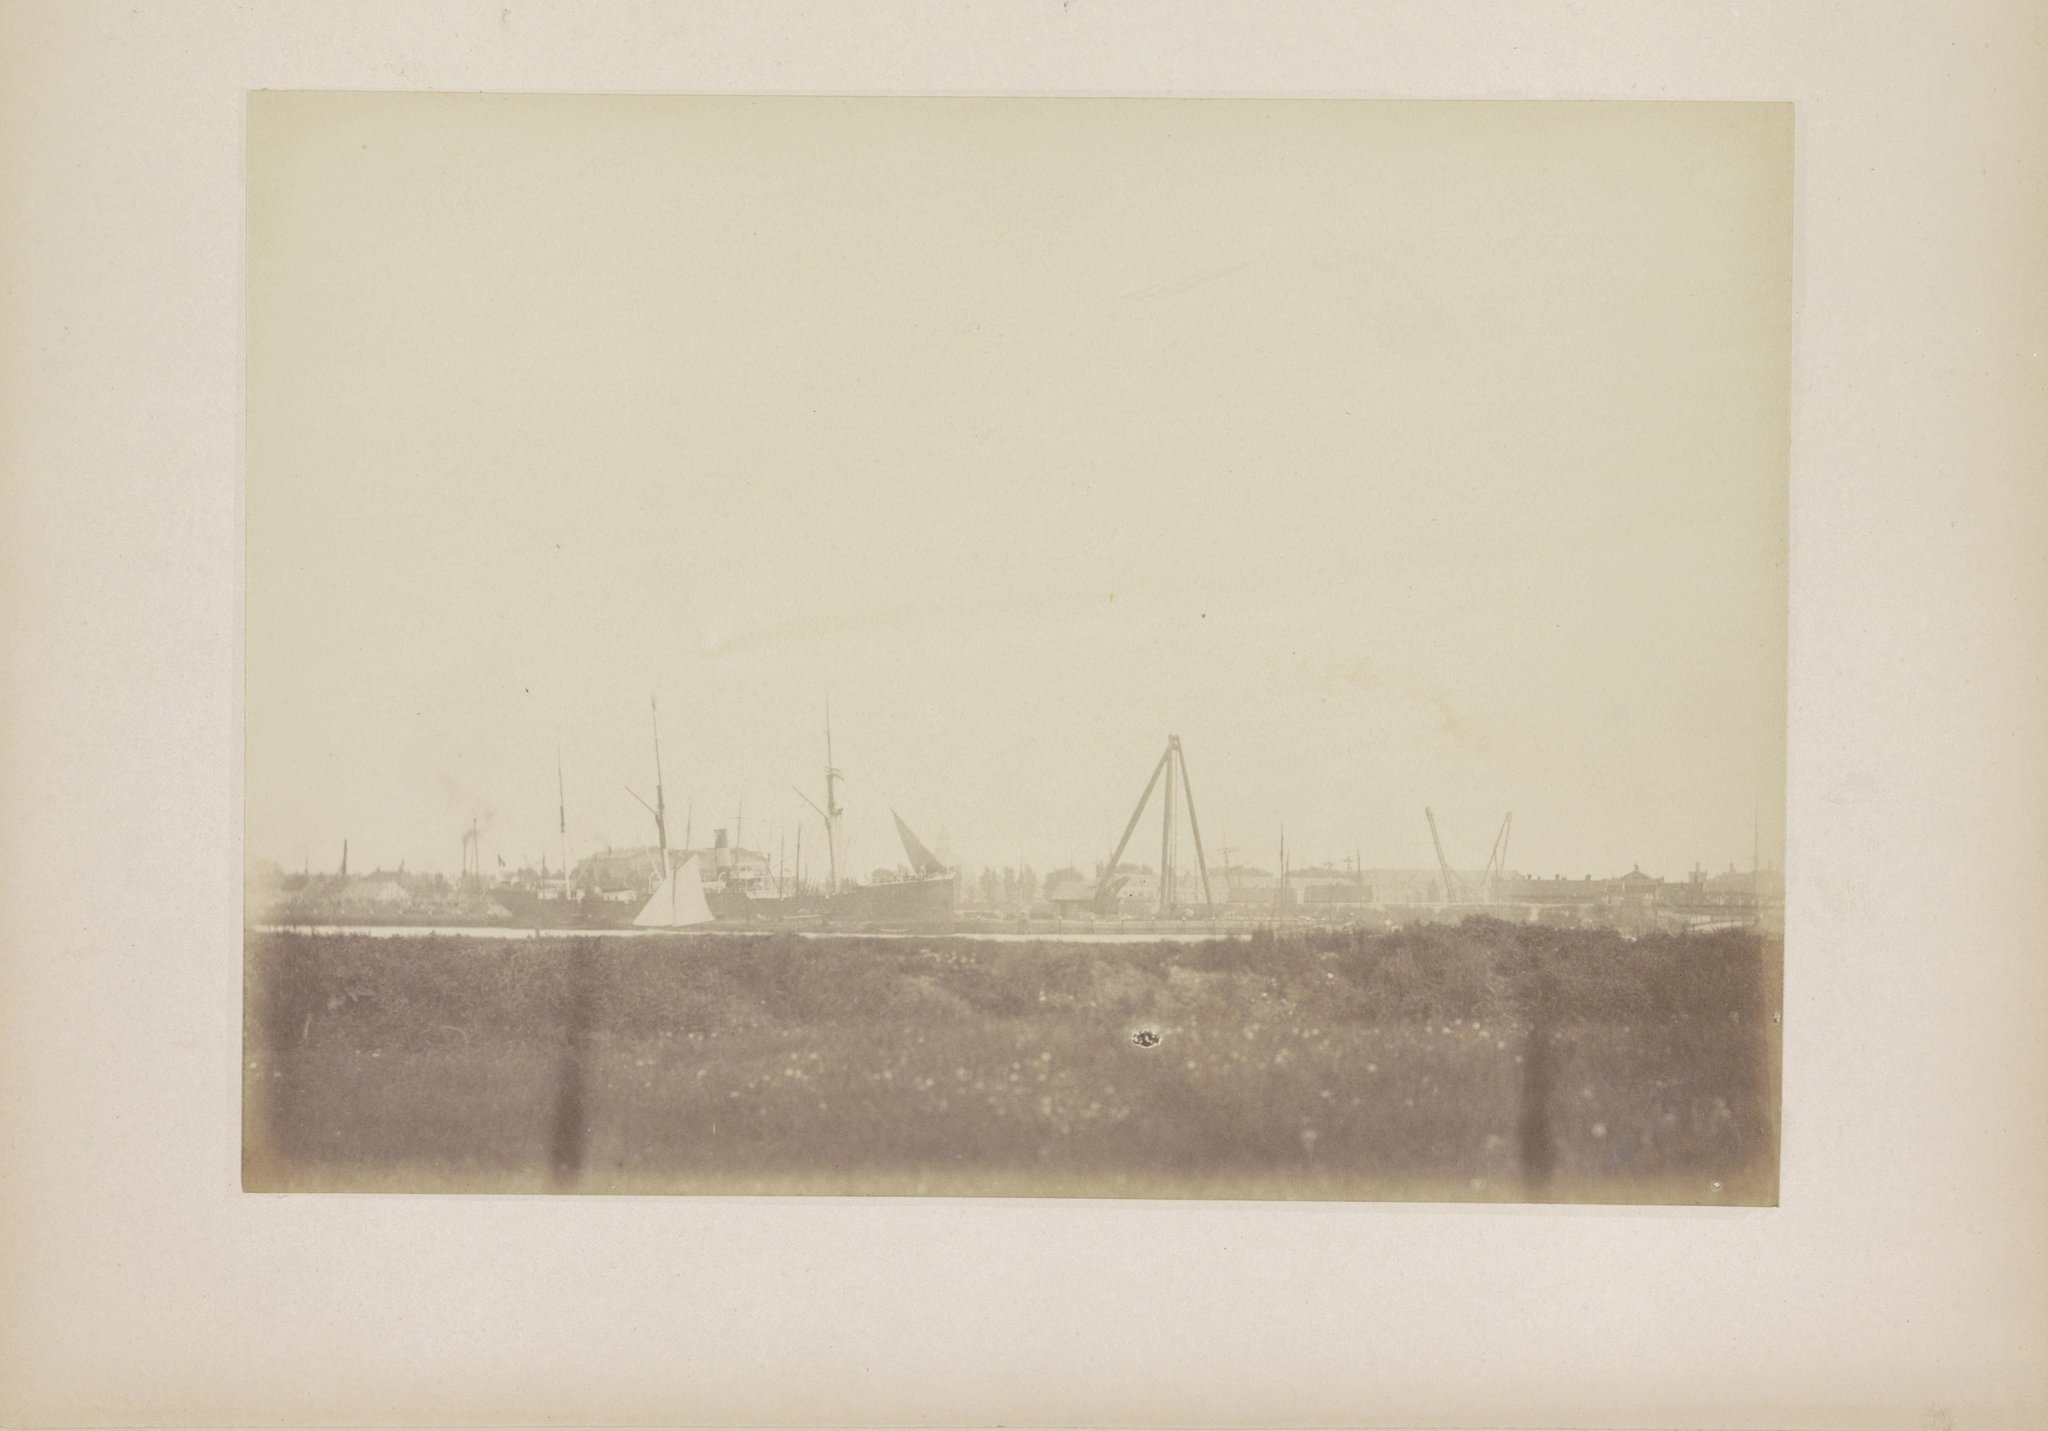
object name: photograph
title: Vrachtschip in de haven van Amsterdam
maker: Anonymous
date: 1885-1900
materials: paper, photographic support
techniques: albumen print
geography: france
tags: harbour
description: Een vrachtschip in de haven van Amsterdam (?), Nederland. Een zeilschip vaart voorbij. Veel bedrijvigheid met heimachines aan de overkant van het water (het IJ?).